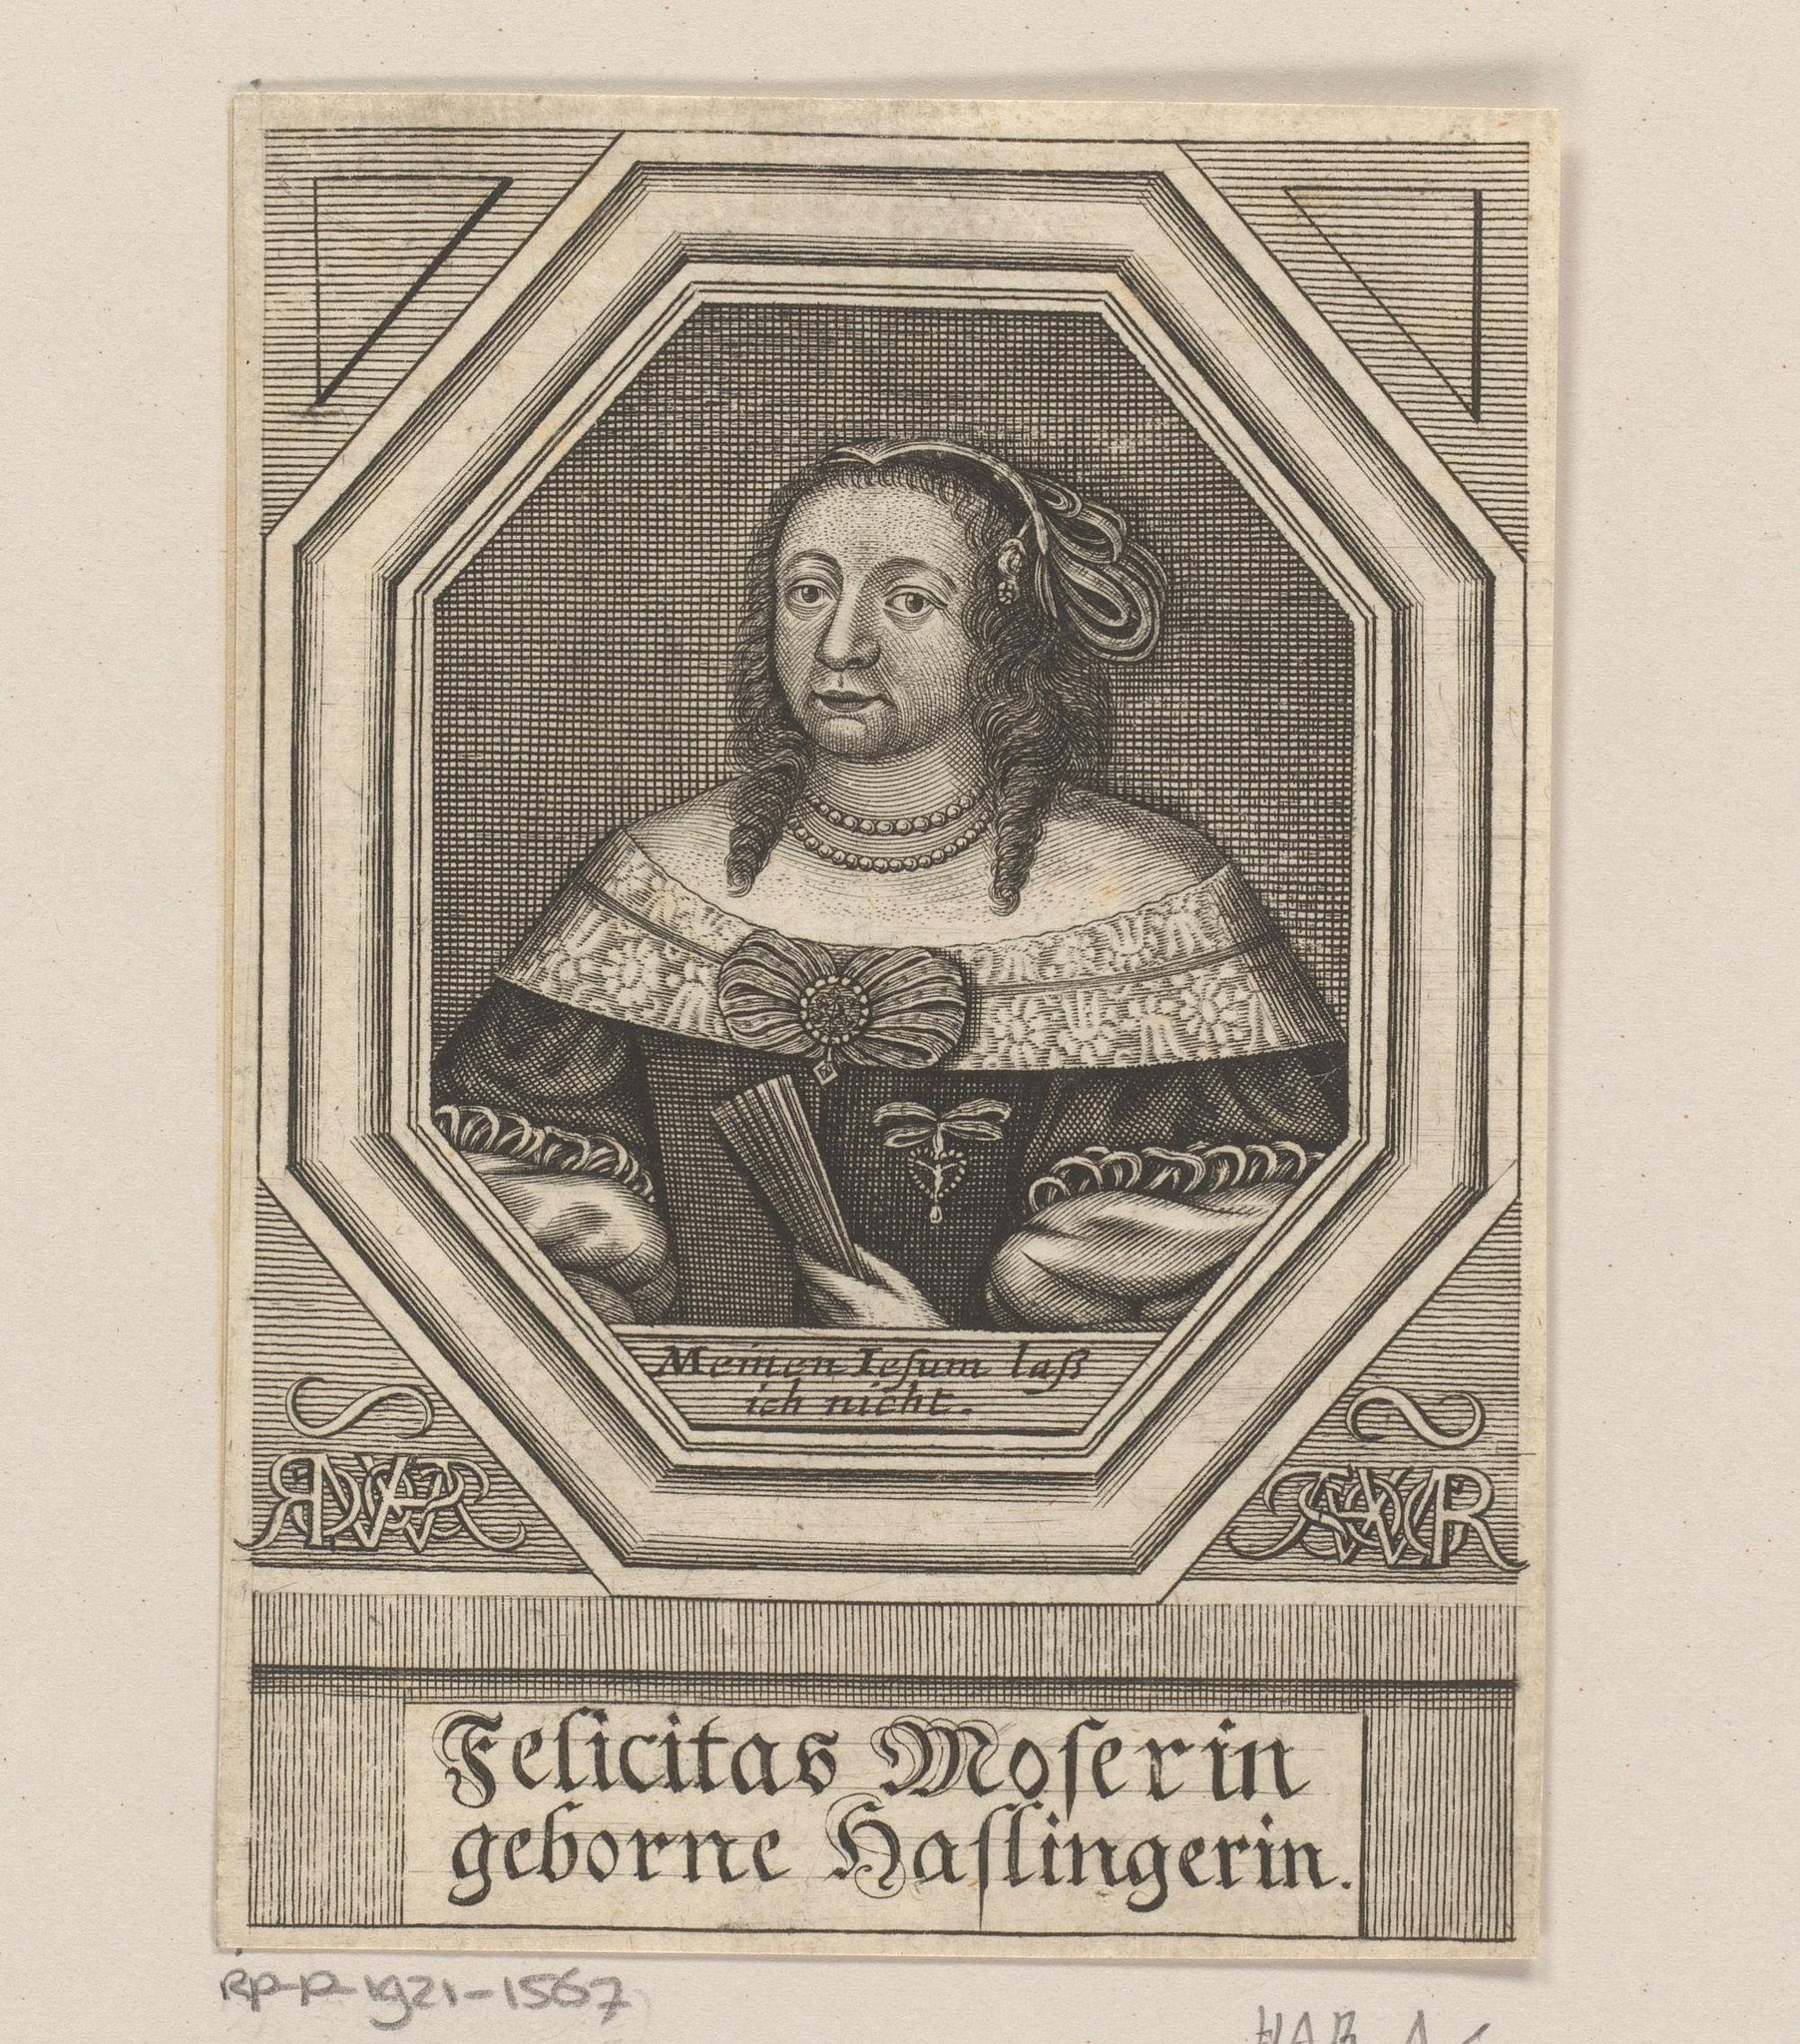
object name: print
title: Portret van Felicitas Haslinger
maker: Anonymous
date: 1550-1700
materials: paper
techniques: engraving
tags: historical persons - bb - woman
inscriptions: collector's mark: Lugt 2233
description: Met tweeregelig onderschrift in het Duits.